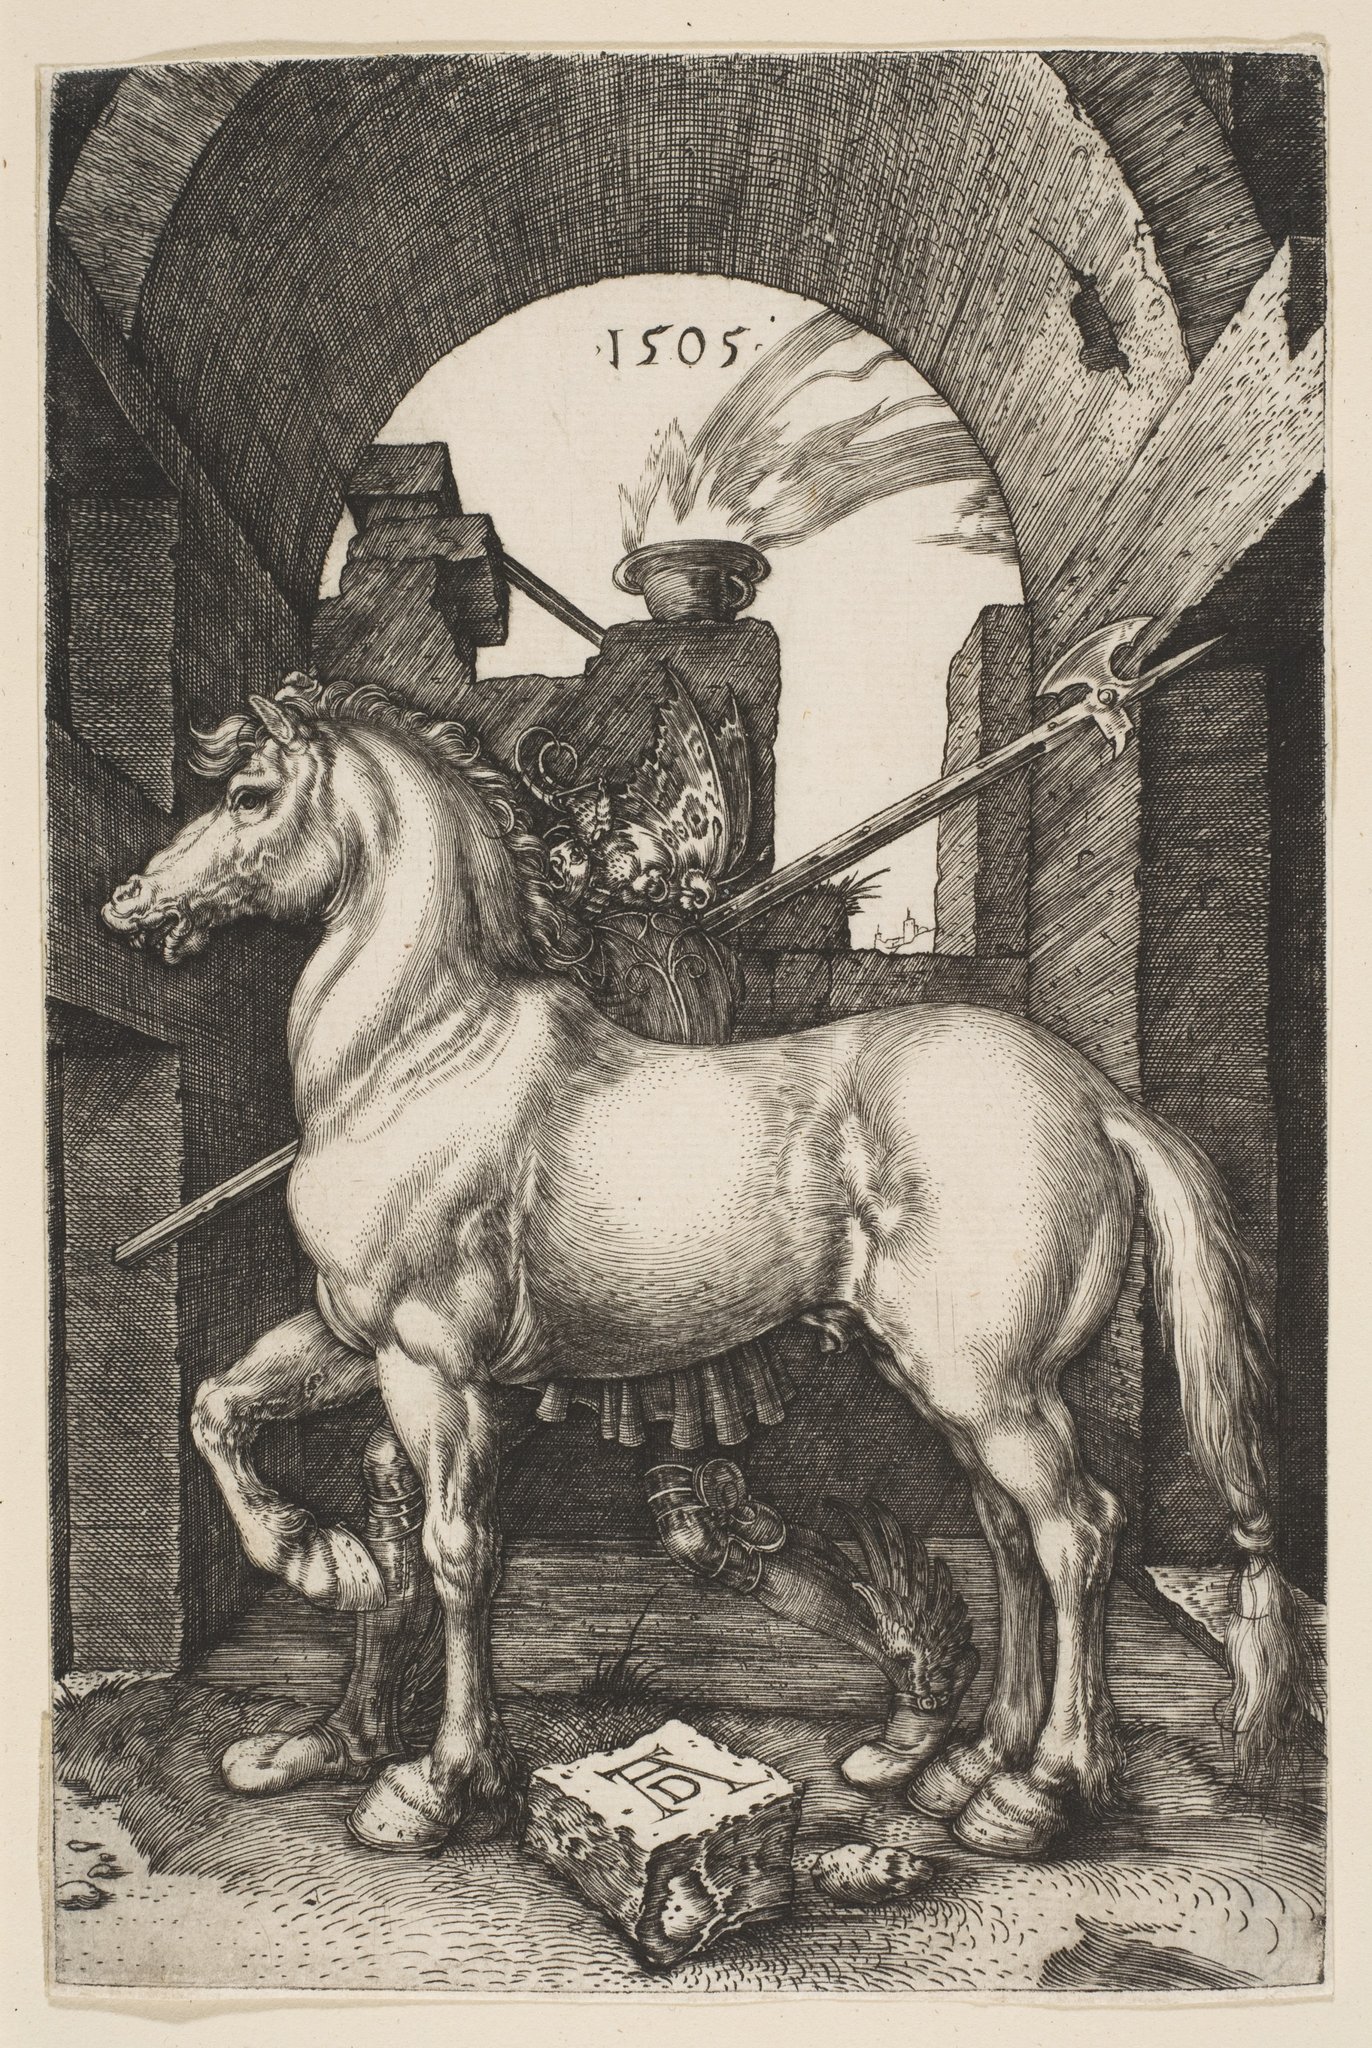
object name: print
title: The Little Horse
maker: albrecht dürer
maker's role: artist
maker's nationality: german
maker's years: 1471-1528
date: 1505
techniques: engraving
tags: weapons,horses